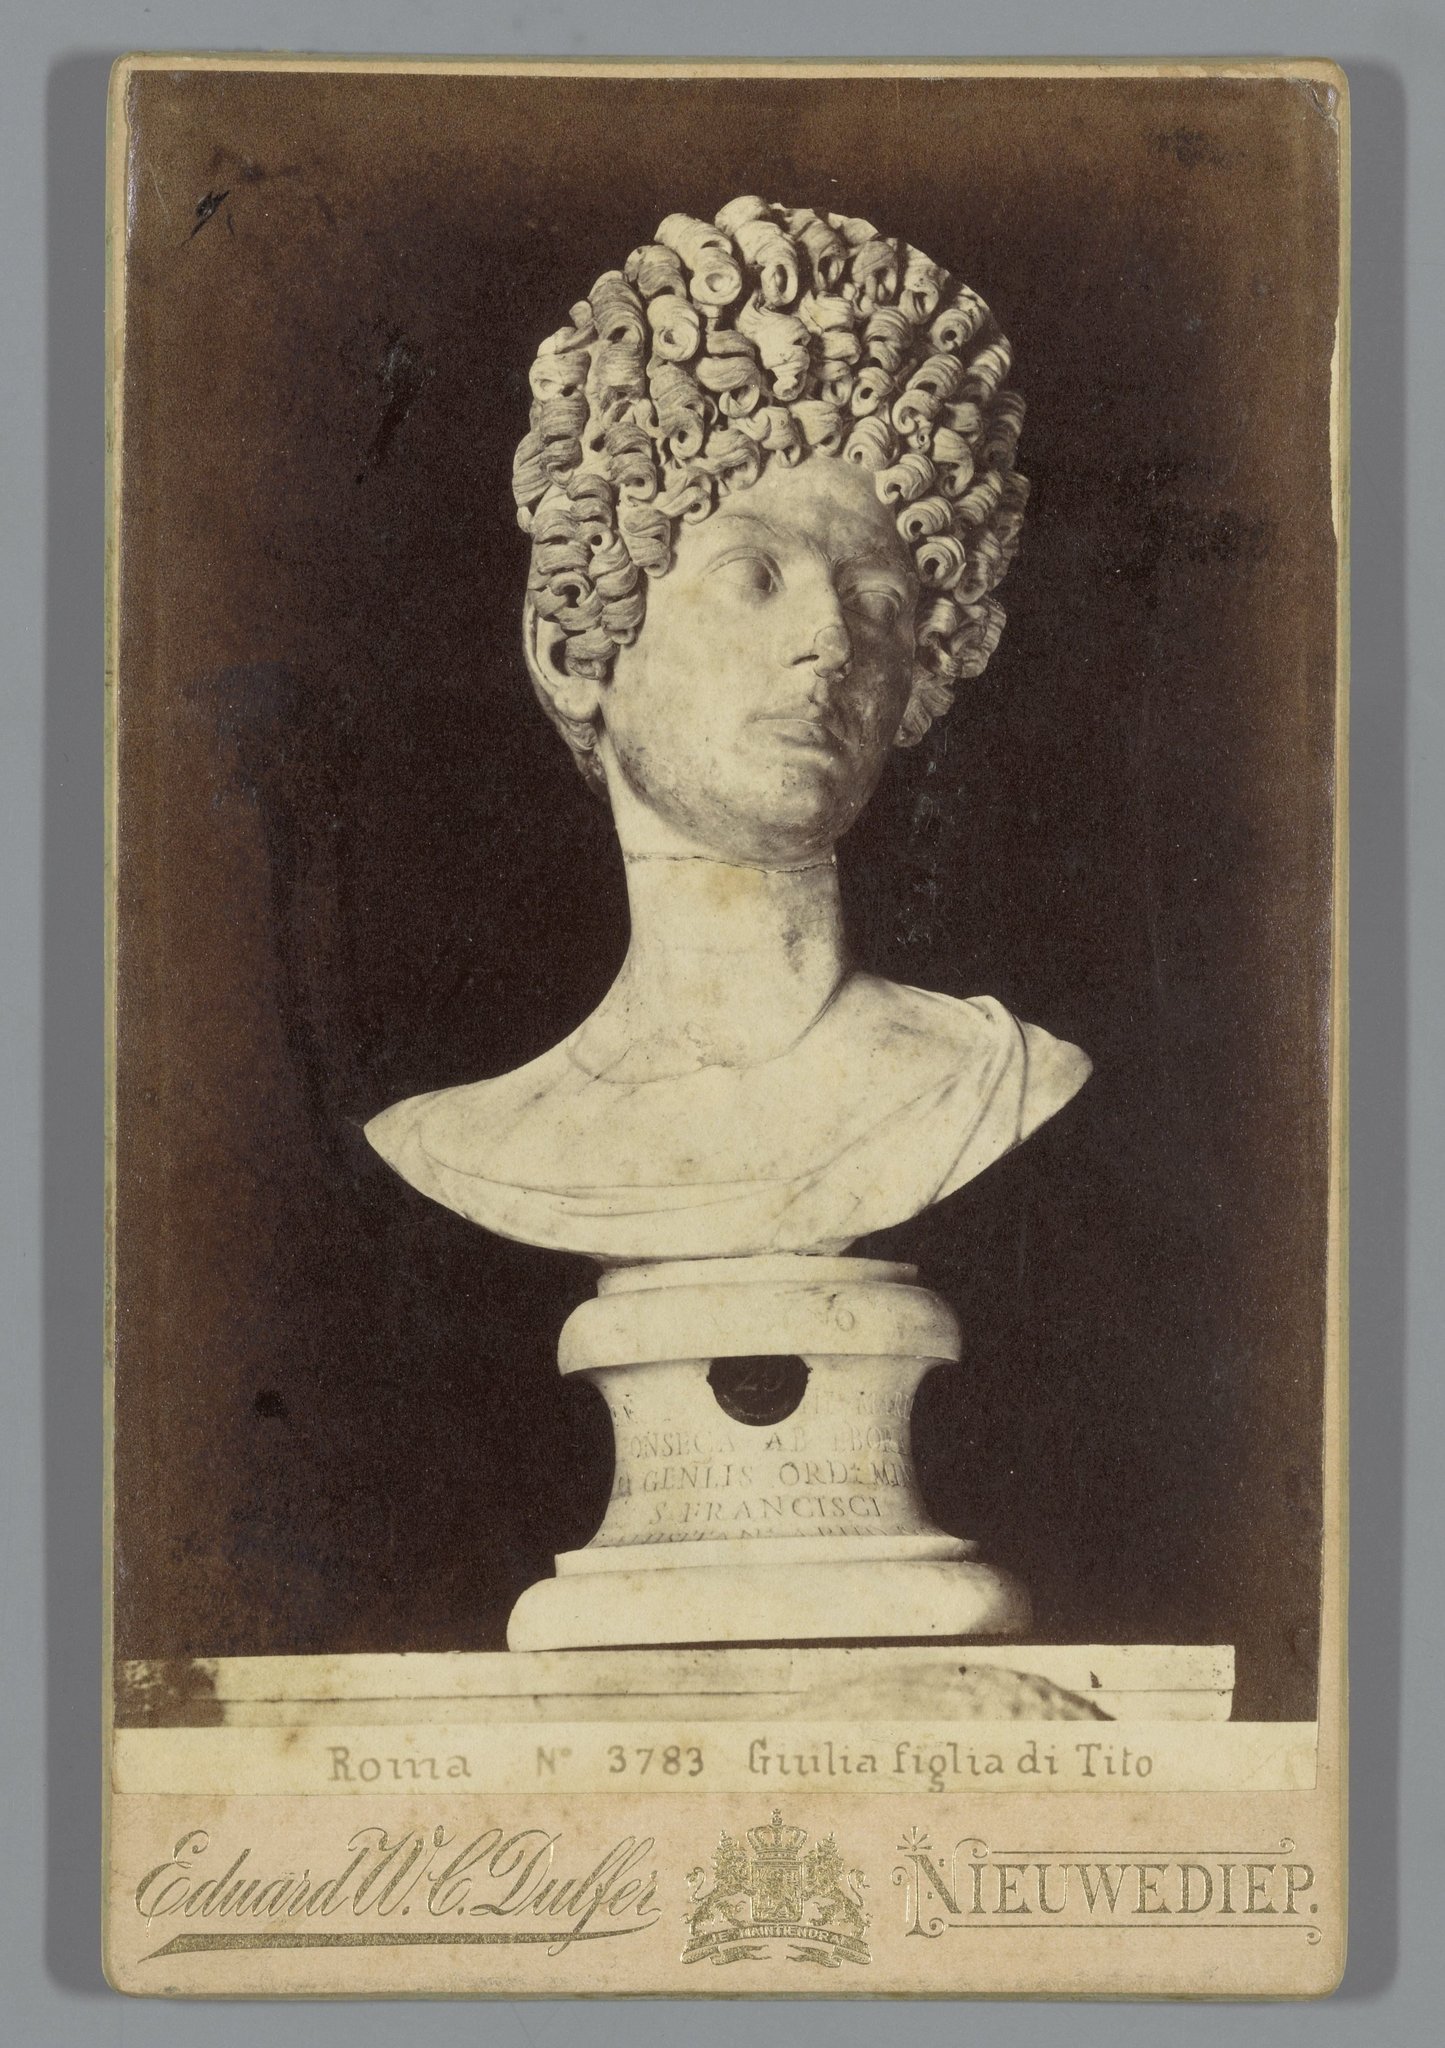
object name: cabinet photograph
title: Romeinse sculptuur van Matidia Minor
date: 1885-1895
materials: cardboard, paper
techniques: albumen print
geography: capitolijnse musea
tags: hair - aa - female human figure, piece of sculpture, reproduction of a piece of sculpture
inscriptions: collector's mark: ‘Vosmaer’